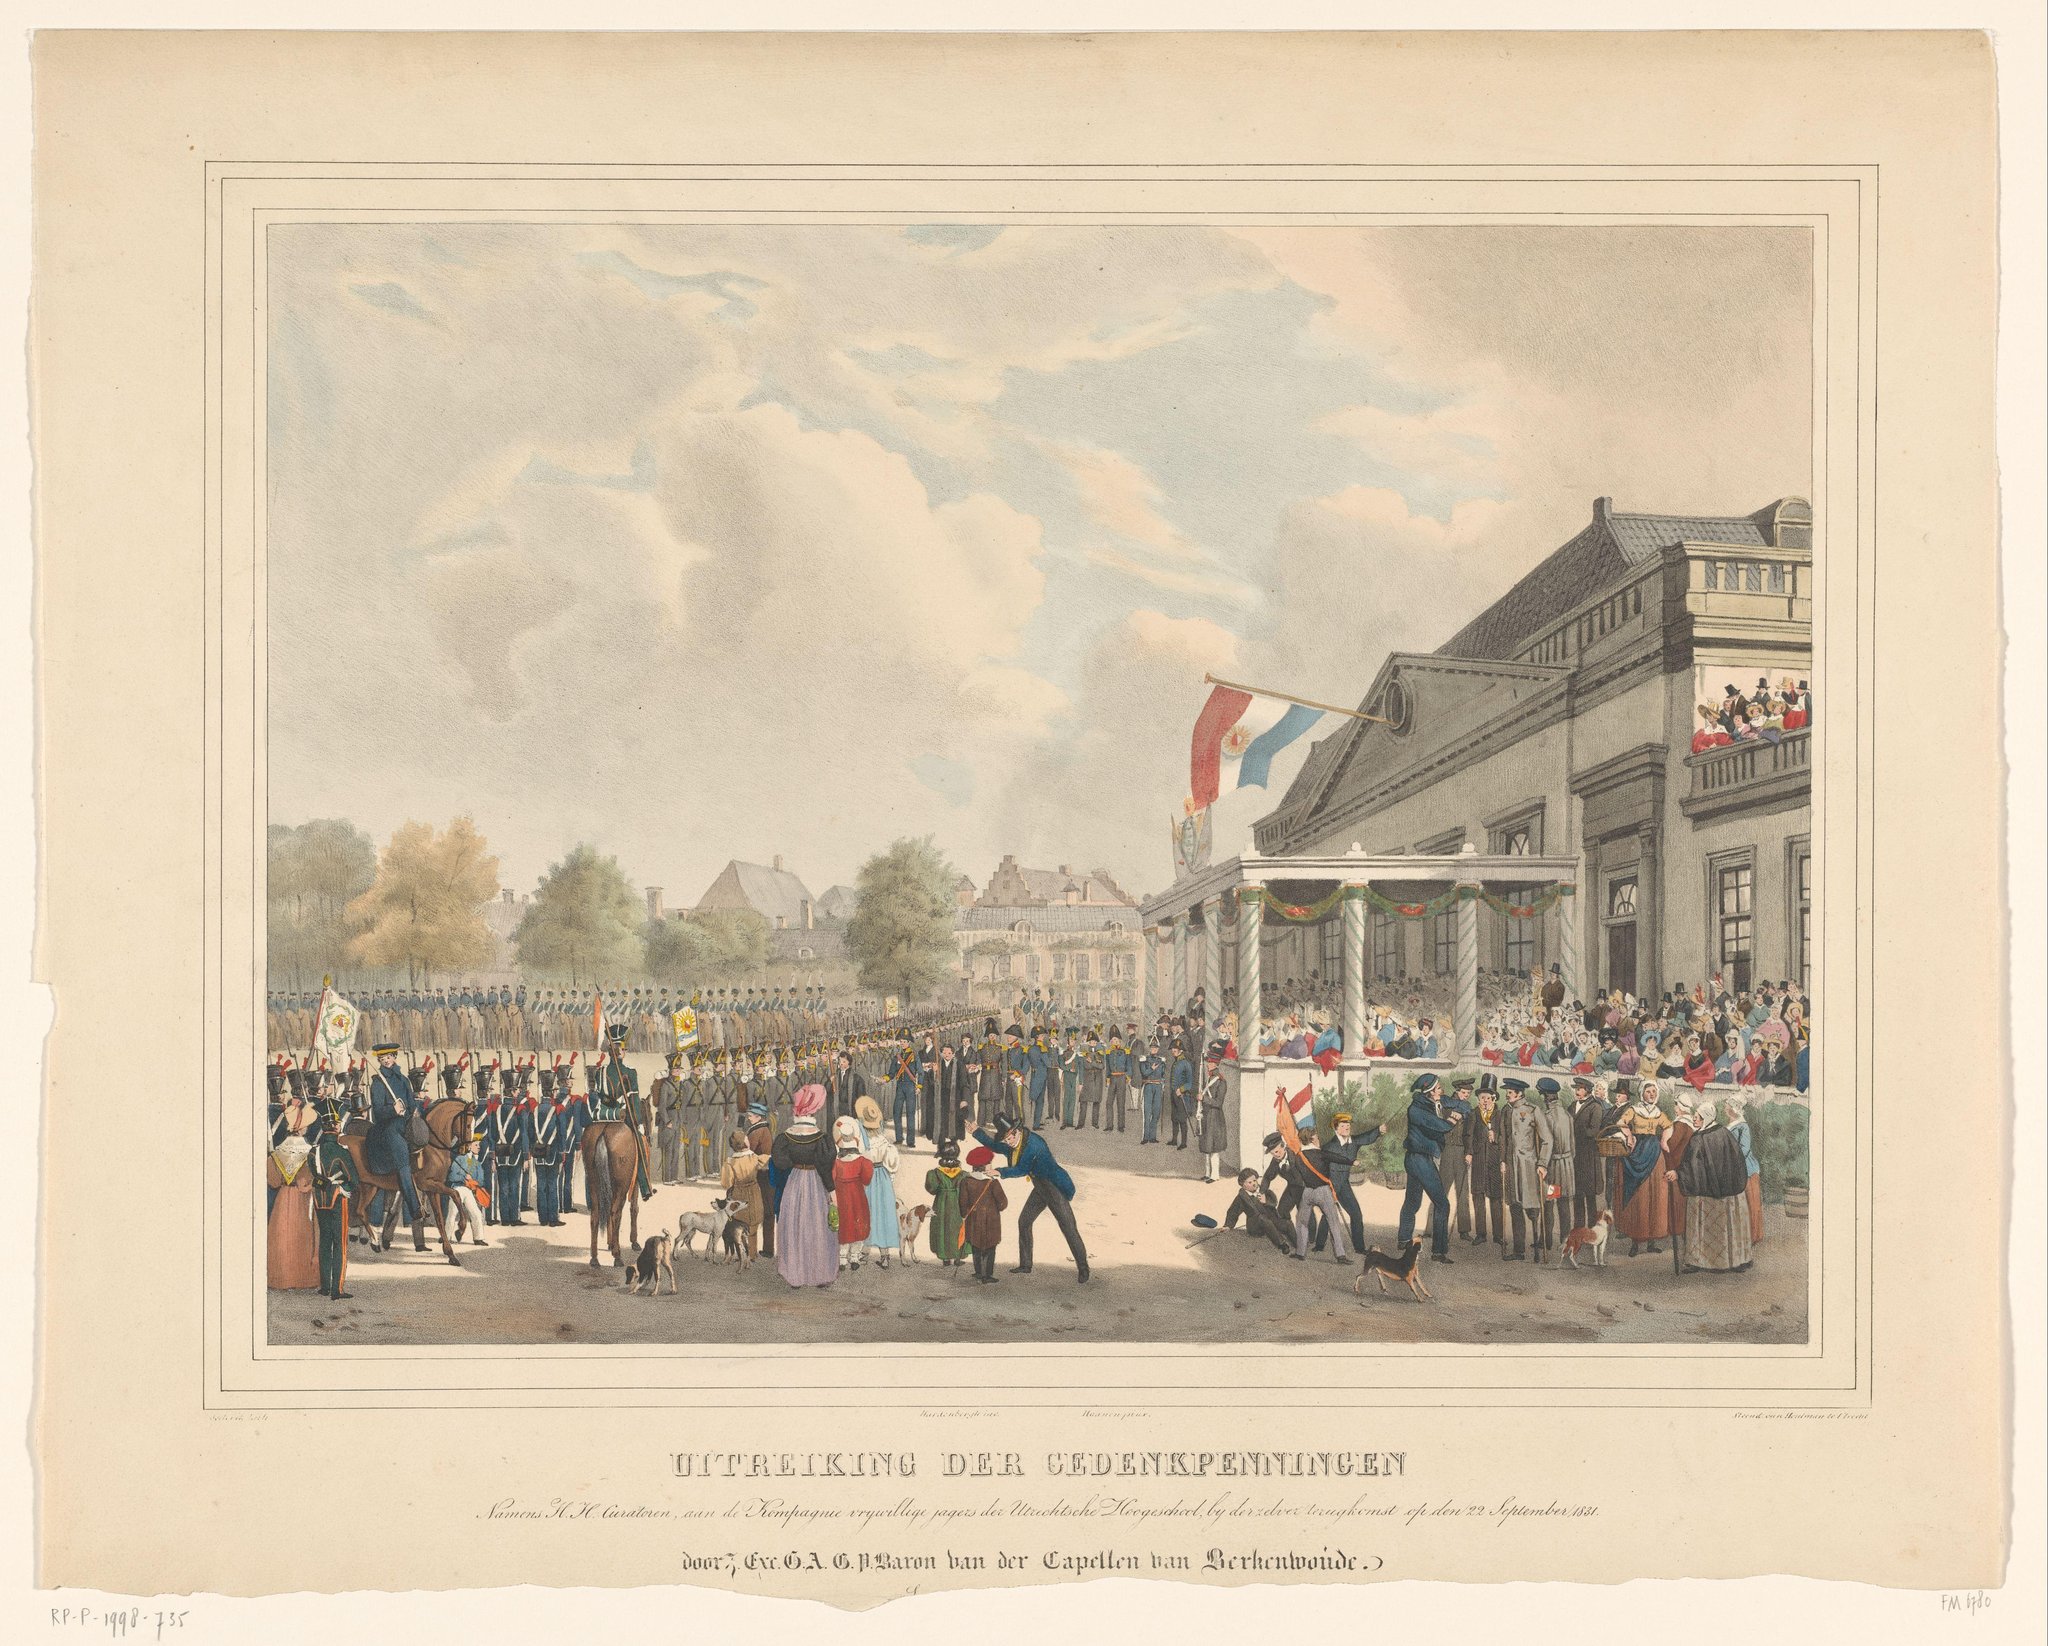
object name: print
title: Uitreiking der Gedenkpenningen Namens H.H. Curatoren, aan de Kompagnie vrijwillige jagers der Utrechtsche Hoogeschool, bij derzelve terugkomst op den 22 September 1831. door Z. Exc. G.A.G.P. Baron van der Capellen van Berkenwoude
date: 1831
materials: paper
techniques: hand coloring, lithograph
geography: utrecht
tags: utrecht, godert alexander gerard philip capellen, medals and other marks of military honour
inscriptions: collector's mark: Lugt 2228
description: Feestelijke uitreiking van de gedenkpenningen aan de teruggekeerde Compagnie Vrijwillige Jagers van de Hogeschool te Utrecht en aan de Rustbewaarders, na de Tiendaagse Veldtocht. Op het Vredenburg voor de Schouwburg te Utrecht op 22 september 1831. De gedenkpenningen worden uitgereikt door Godert Alexander Gerard Philip baron van der Capellen.